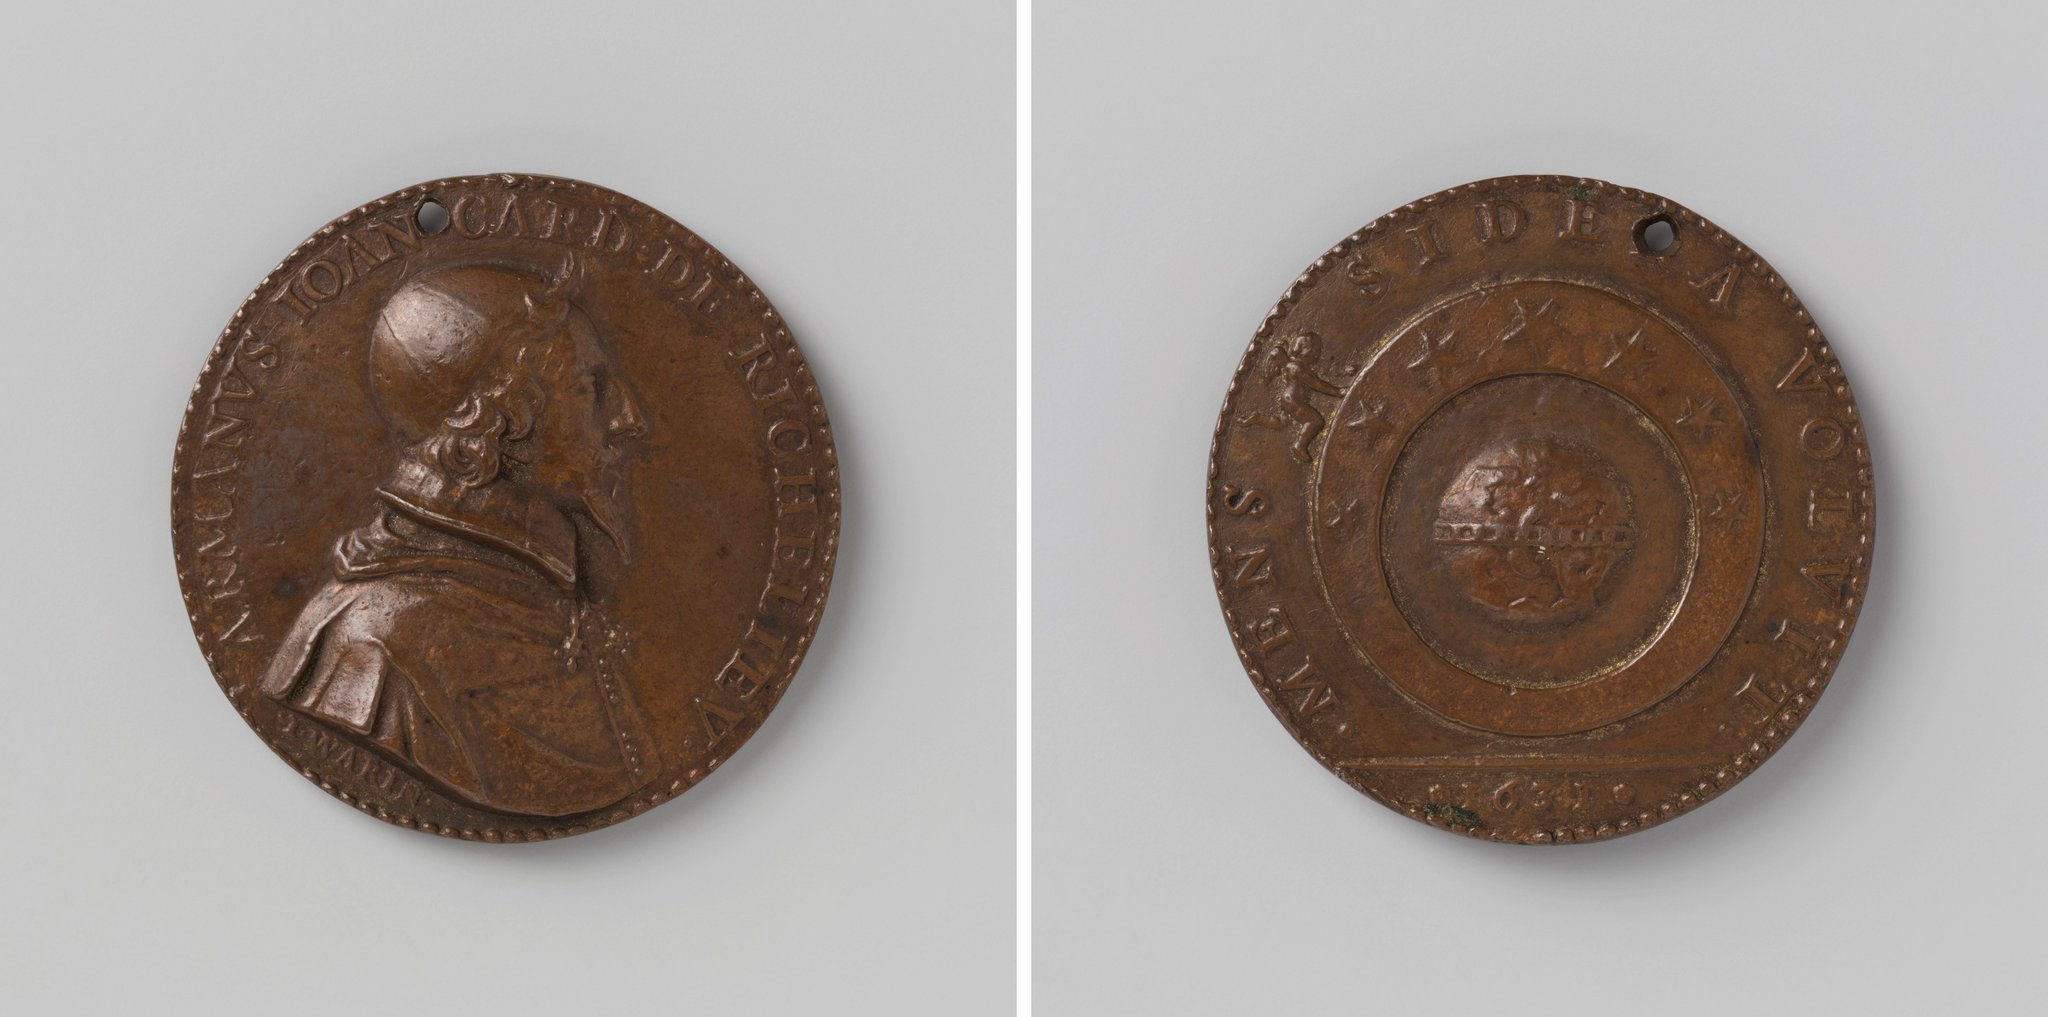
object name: honorary medal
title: Kardinaal Richelieu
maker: jean warin (ii)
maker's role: medailleur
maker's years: 1596-1672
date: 1631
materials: bronze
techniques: striking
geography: paris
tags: paris, armand-jean du plessis hertog van richelieu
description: Bronzen penning met gat erin. Voorzijde: borststuk man binnen omschrift. Keerzijde: globe binnen sterrenrand, waarop een genius zit binnen omschrift.